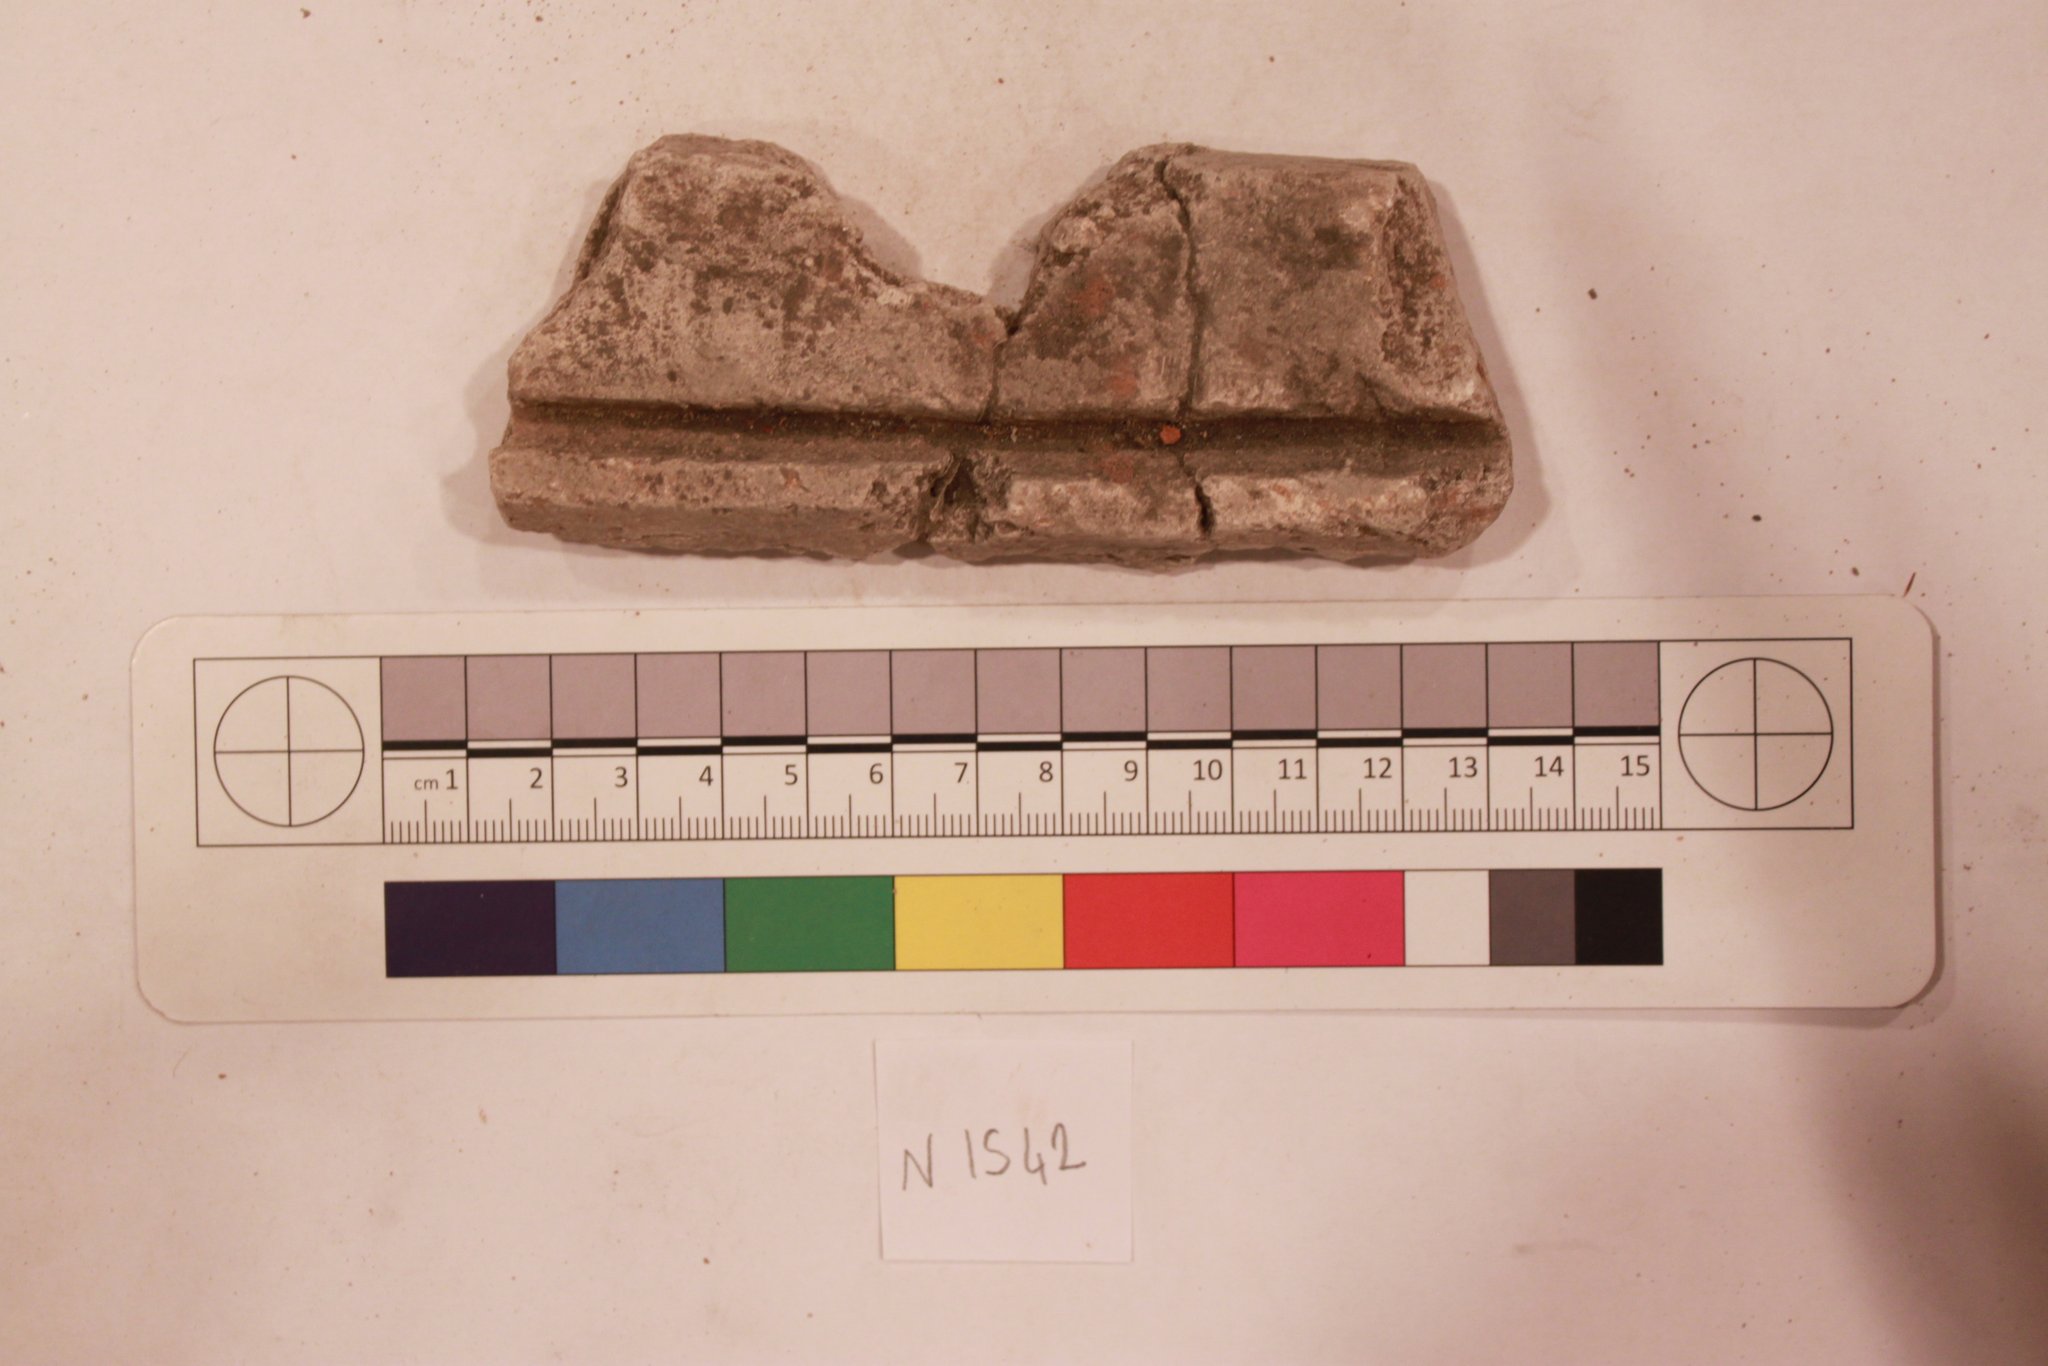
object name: fragment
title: Stucco Fragment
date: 701-1200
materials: plaster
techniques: carving, painting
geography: iran